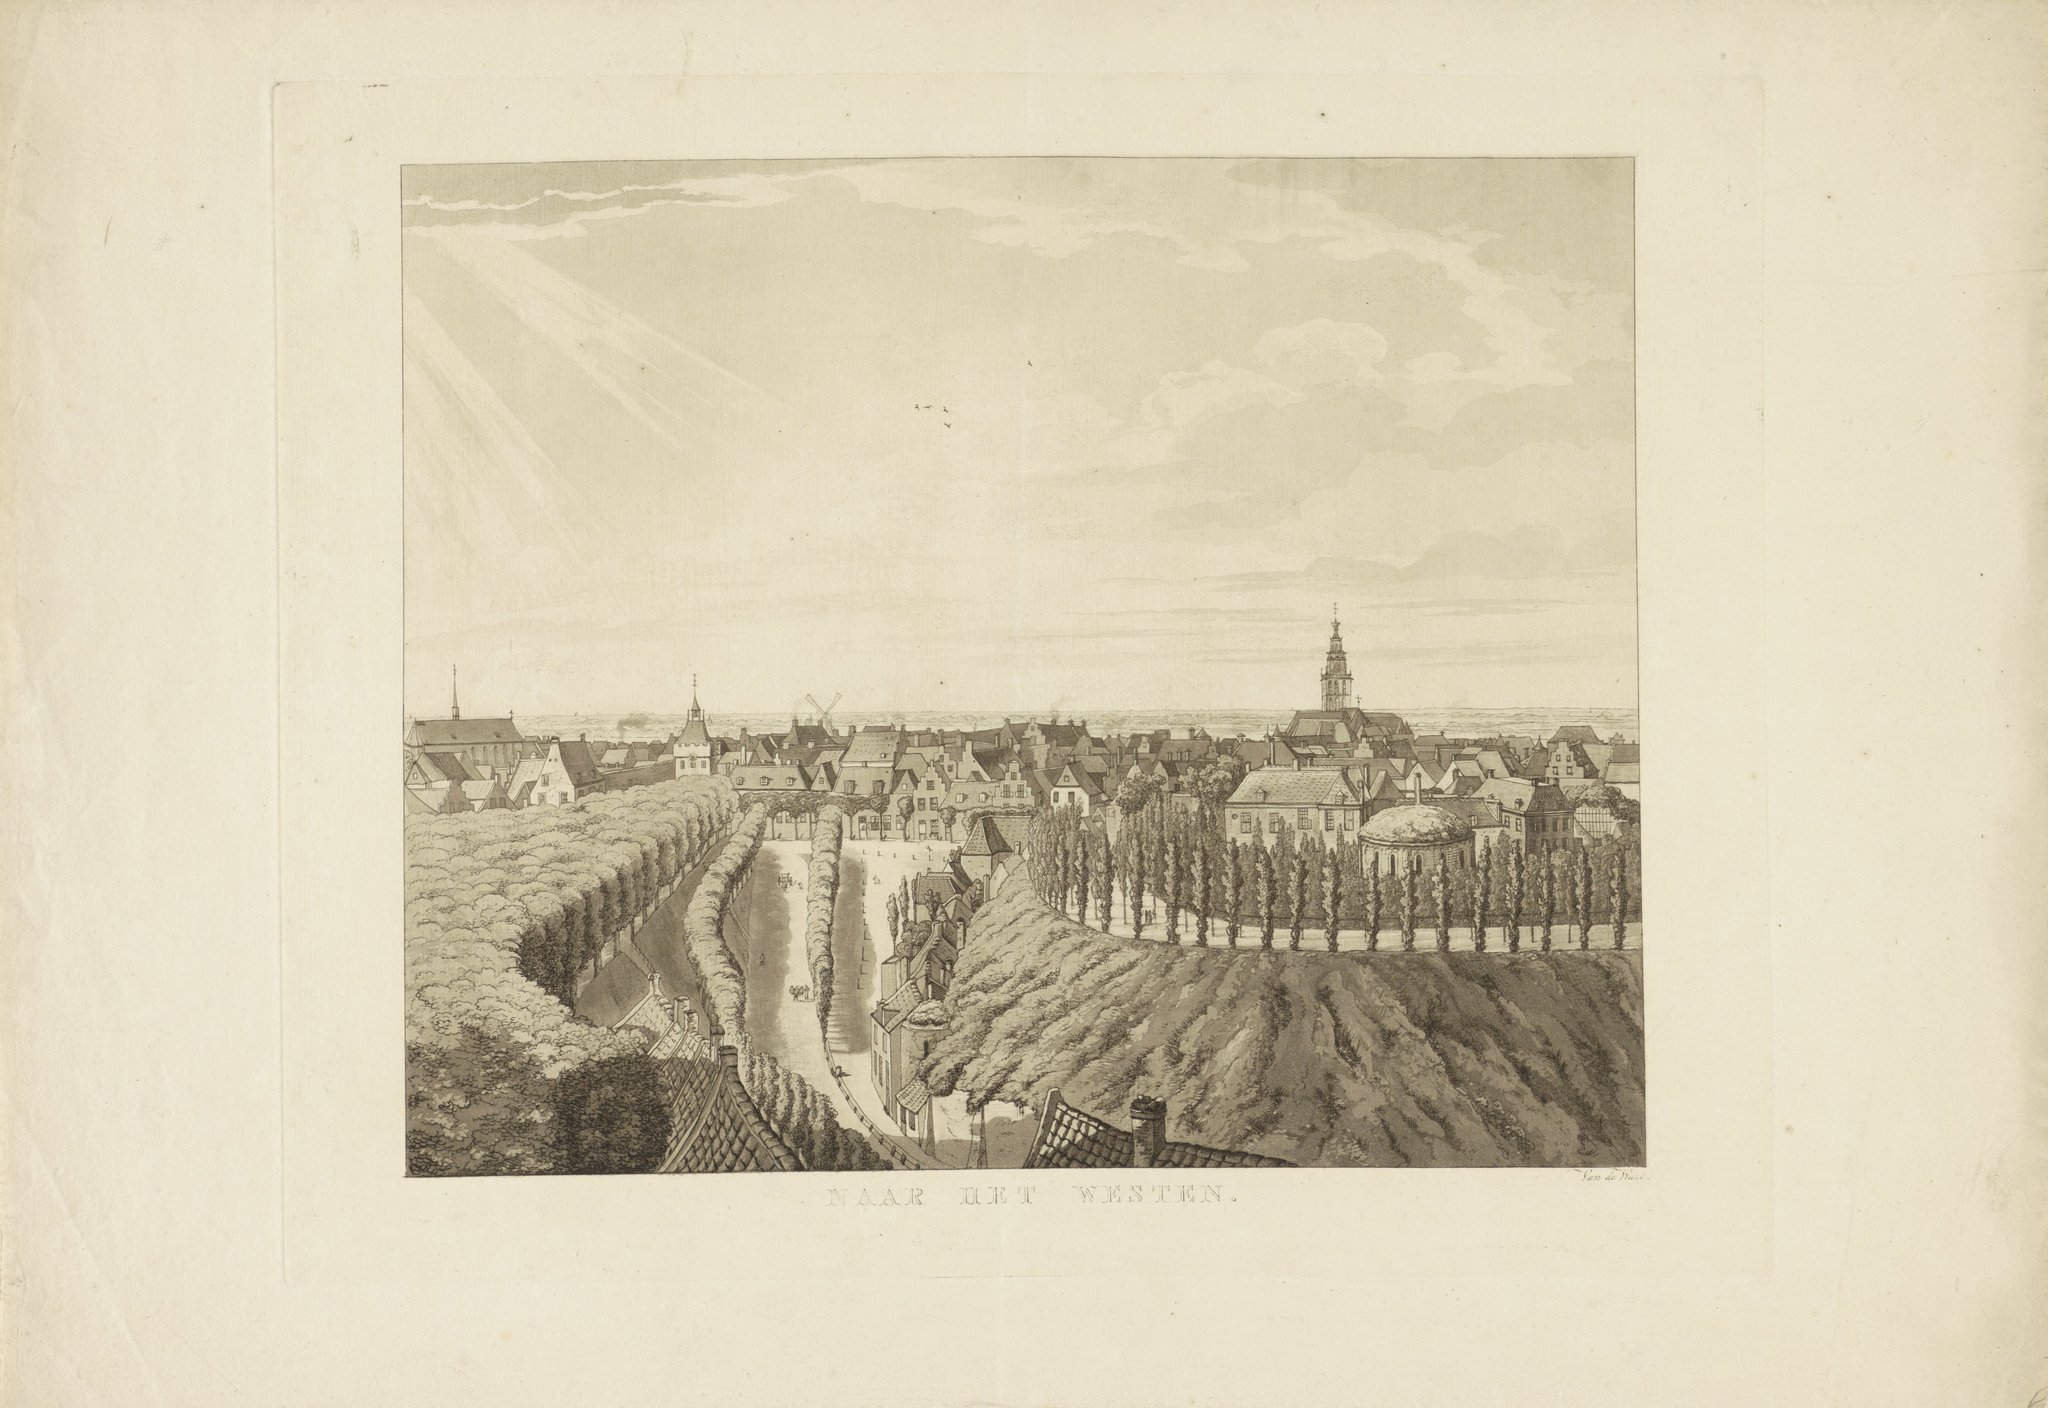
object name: print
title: Geldersch panorama of rondgezicht naar het leven geteekend op belvedére te Nymegen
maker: derk anthony van de wart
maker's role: draughtsman, painter, print maker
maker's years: 1767-1824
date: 1815-1824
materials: paper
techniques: aquatint, etching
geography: nijmegen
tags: landscapes in the temperate zone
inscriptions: collector's mark: Lugt 2760, collector's mark: Lugt 2228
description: Nijmegen, zicht vanuit de Belvédère richting het westen. Weergegeven zijn de Stevenskerk, de Gasthuiskerk, het Valkhof met de Barbarossa-ruïne, de Burchtpoort en het Kelfkensbos. De prent is een onderdeel van een suite van negen prenten, inclusief de titelprent.